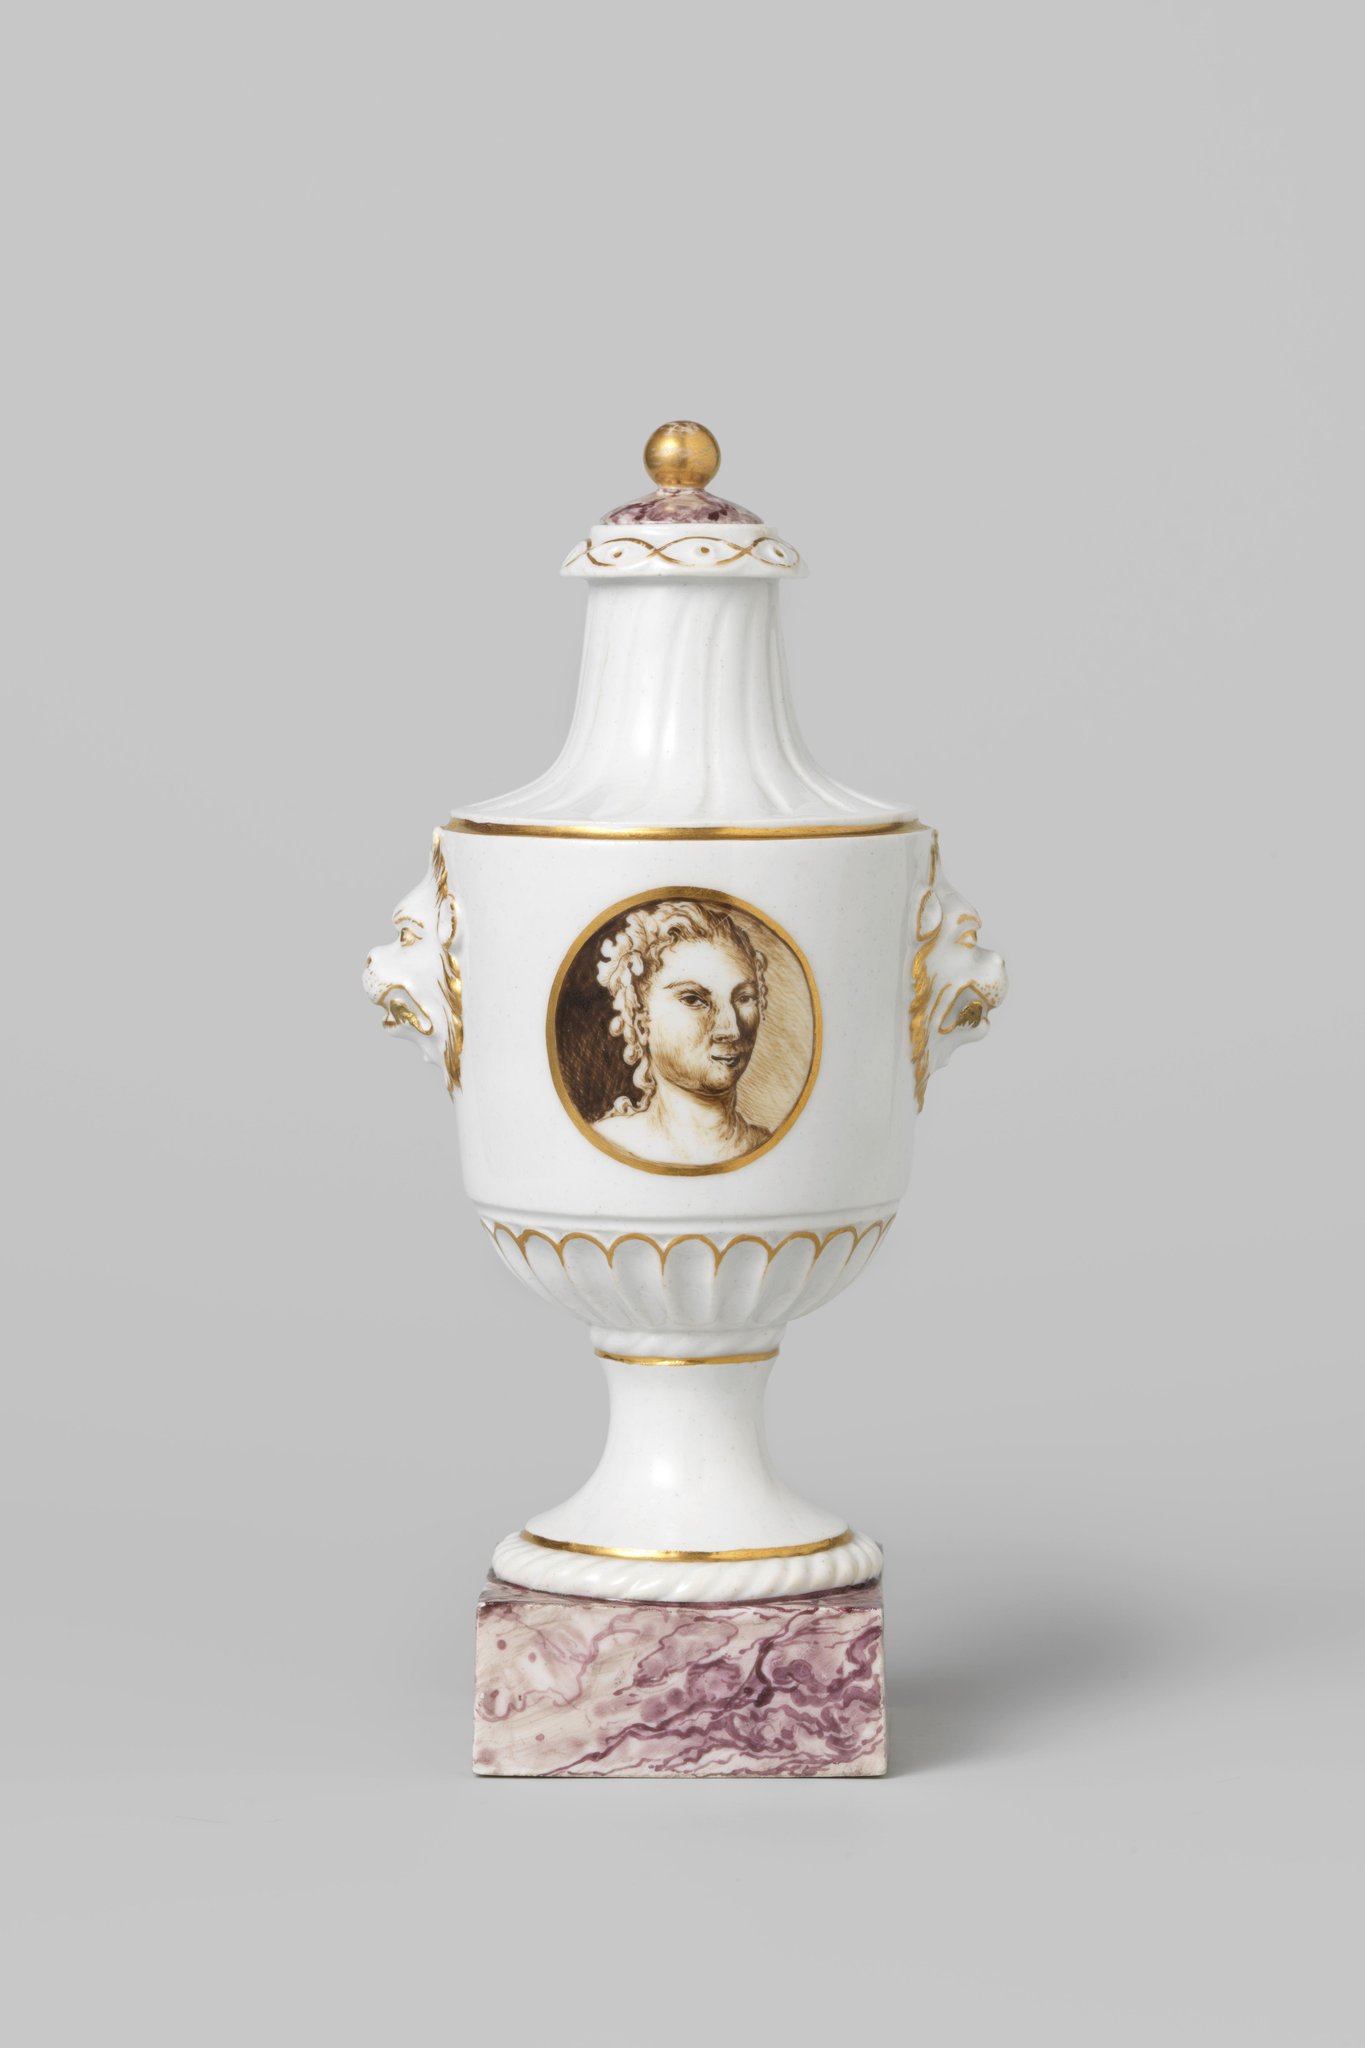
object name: vase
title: Vaas beschilderd met parelhoenders in landschap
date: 1774-1784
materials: porcelain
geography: loosdrecht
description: Three vases and covers. Porcelain. Loosdrecht, c. 1778 - 1782. Factory of Joannes de Mol.